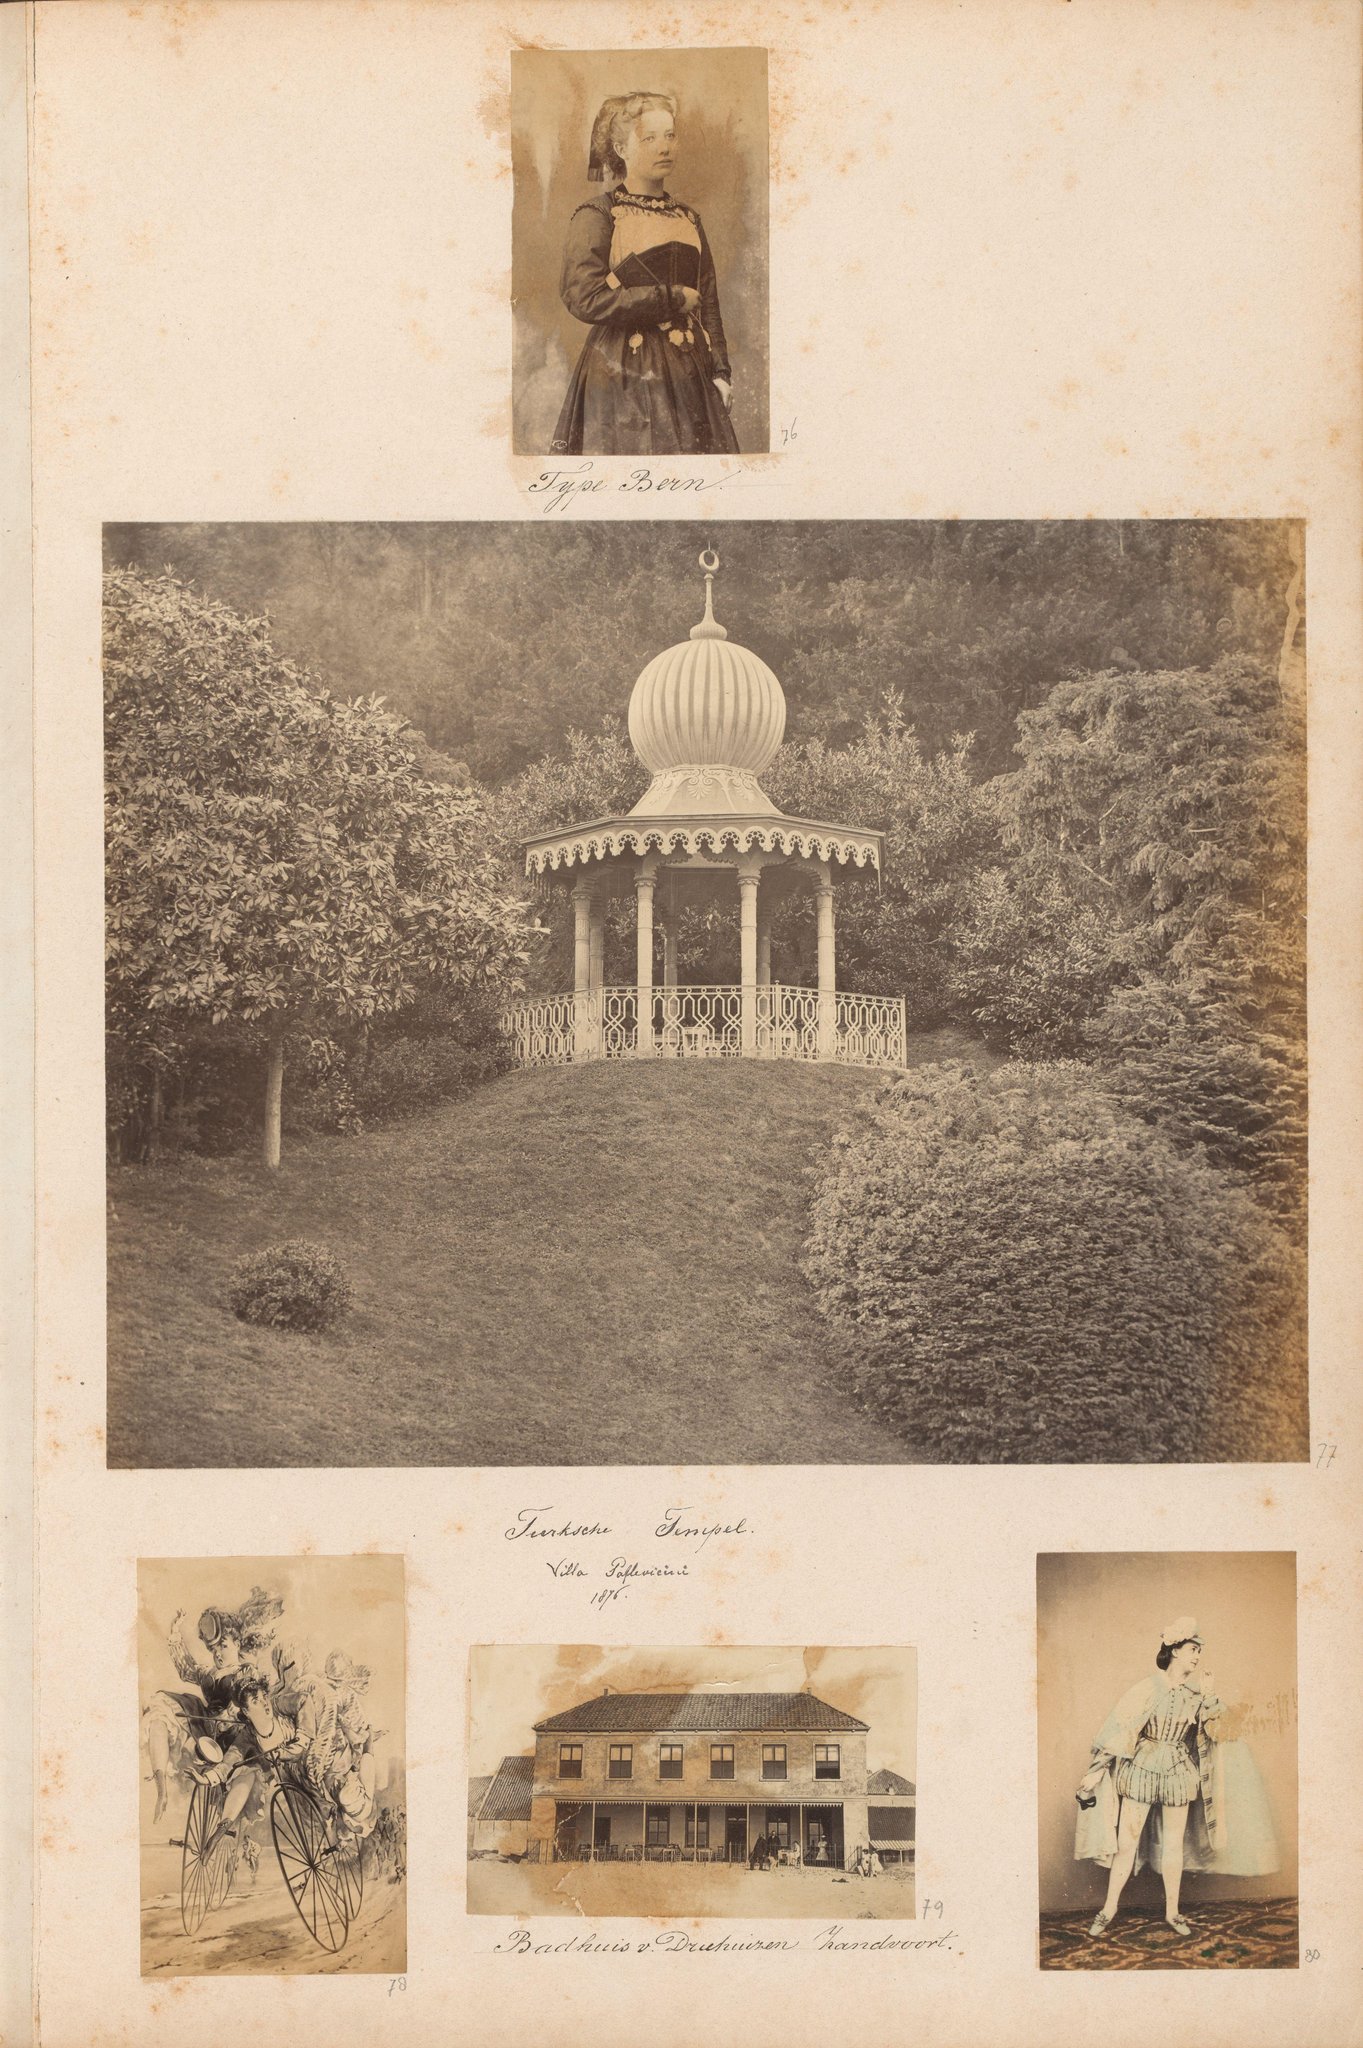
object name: photograph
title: Fotoreproductie van een spotprent van twee fietsende vrouwen aan het strand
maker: Anonymous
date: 1870-1880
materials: paper, photographic support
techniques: albumen print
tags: adult woman, bicycle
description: Onderdeel van Fotoalbum van Robert Daniel Crommelin (1841-1907).